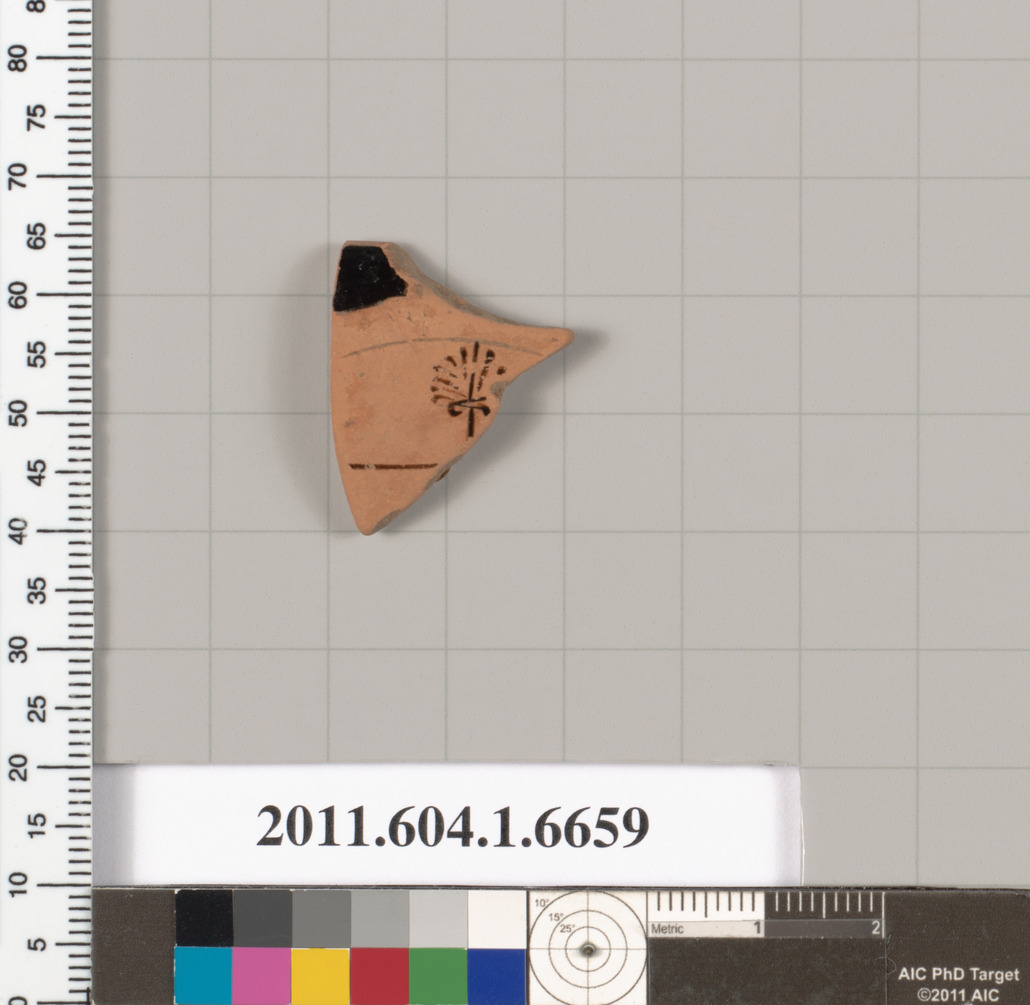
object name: kylix fragment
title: Terracotta rim fragment of a kylix (drinking cup)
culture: greek, attic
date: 490-470 BCE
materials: terracotta